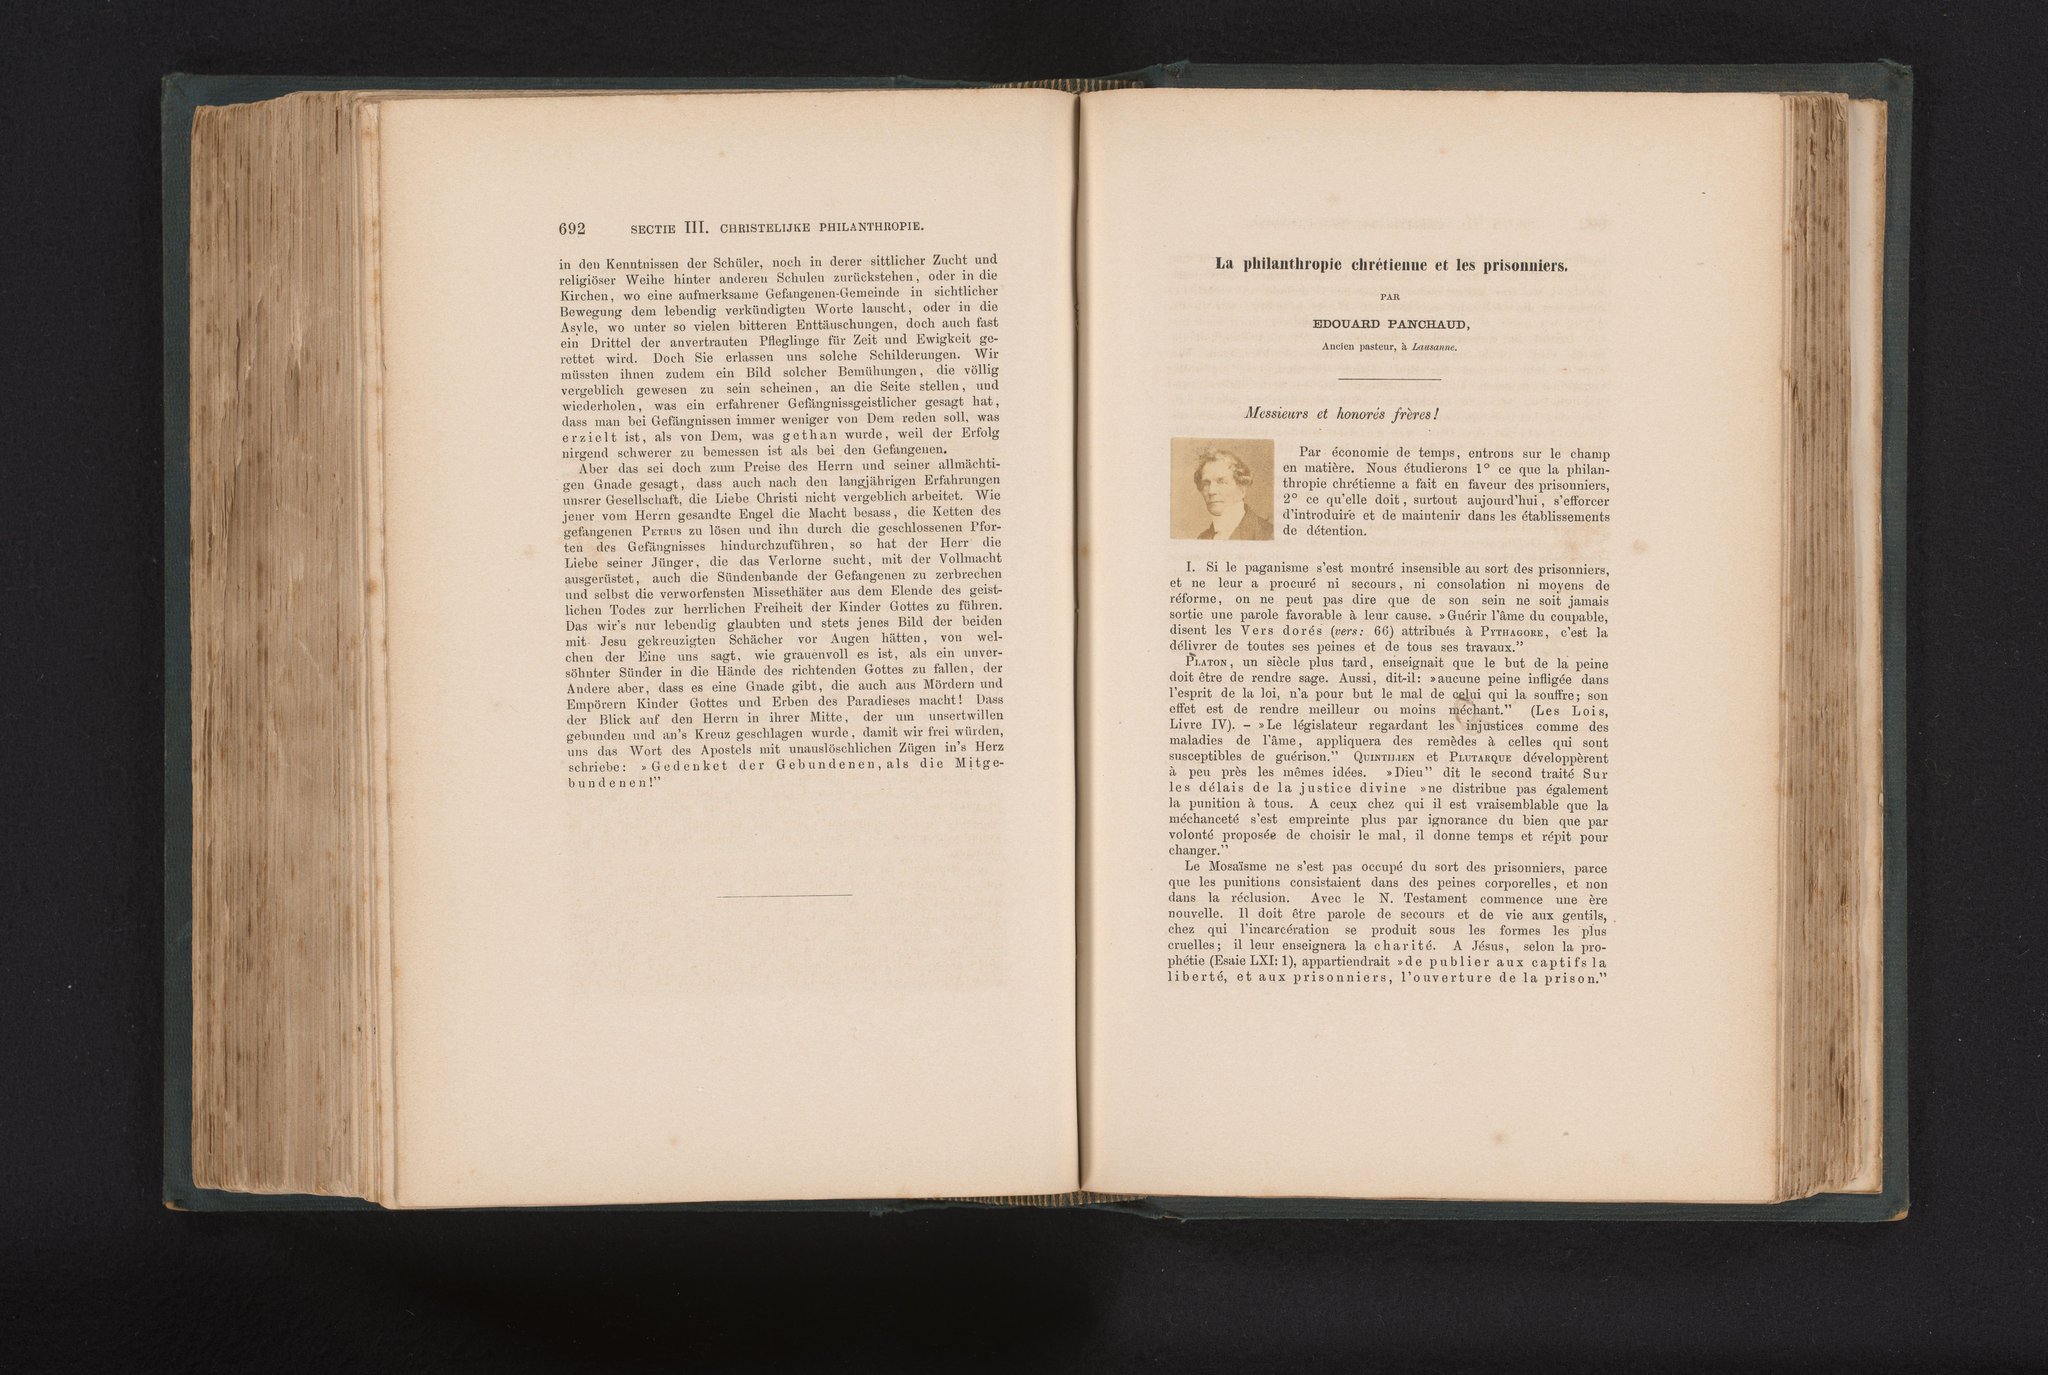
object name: page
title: Portret van pastoor Edouard Panchaud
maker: Anonymous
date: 1855-1867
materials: paper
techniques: albumen print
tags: adult man, historical persons